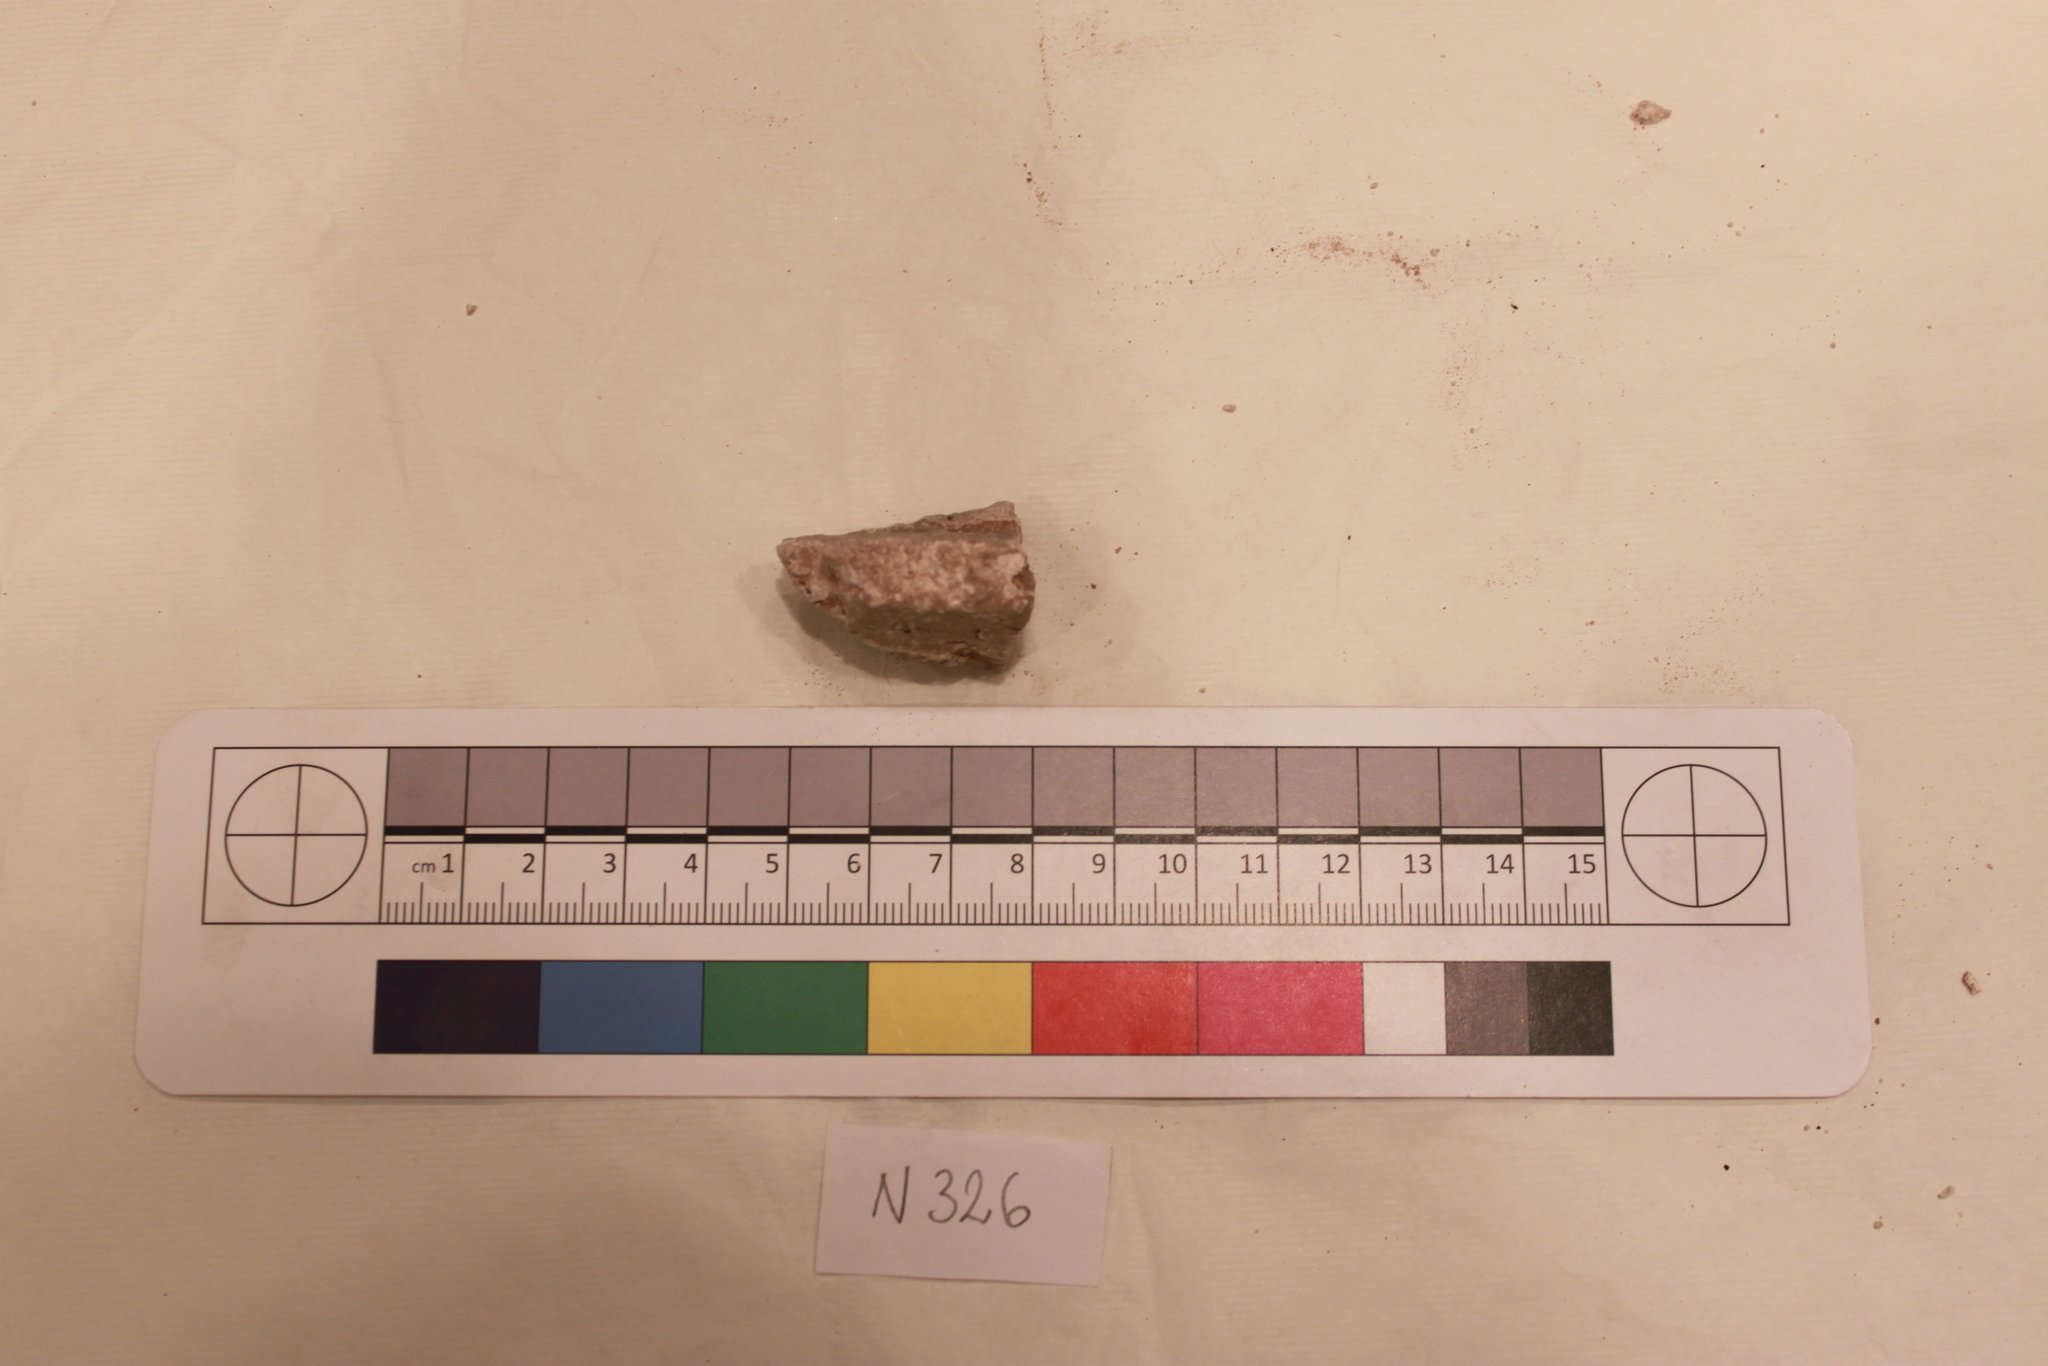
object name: fragment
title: Stucco Fragment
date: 701-1200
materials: plaster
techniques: carving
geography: iran